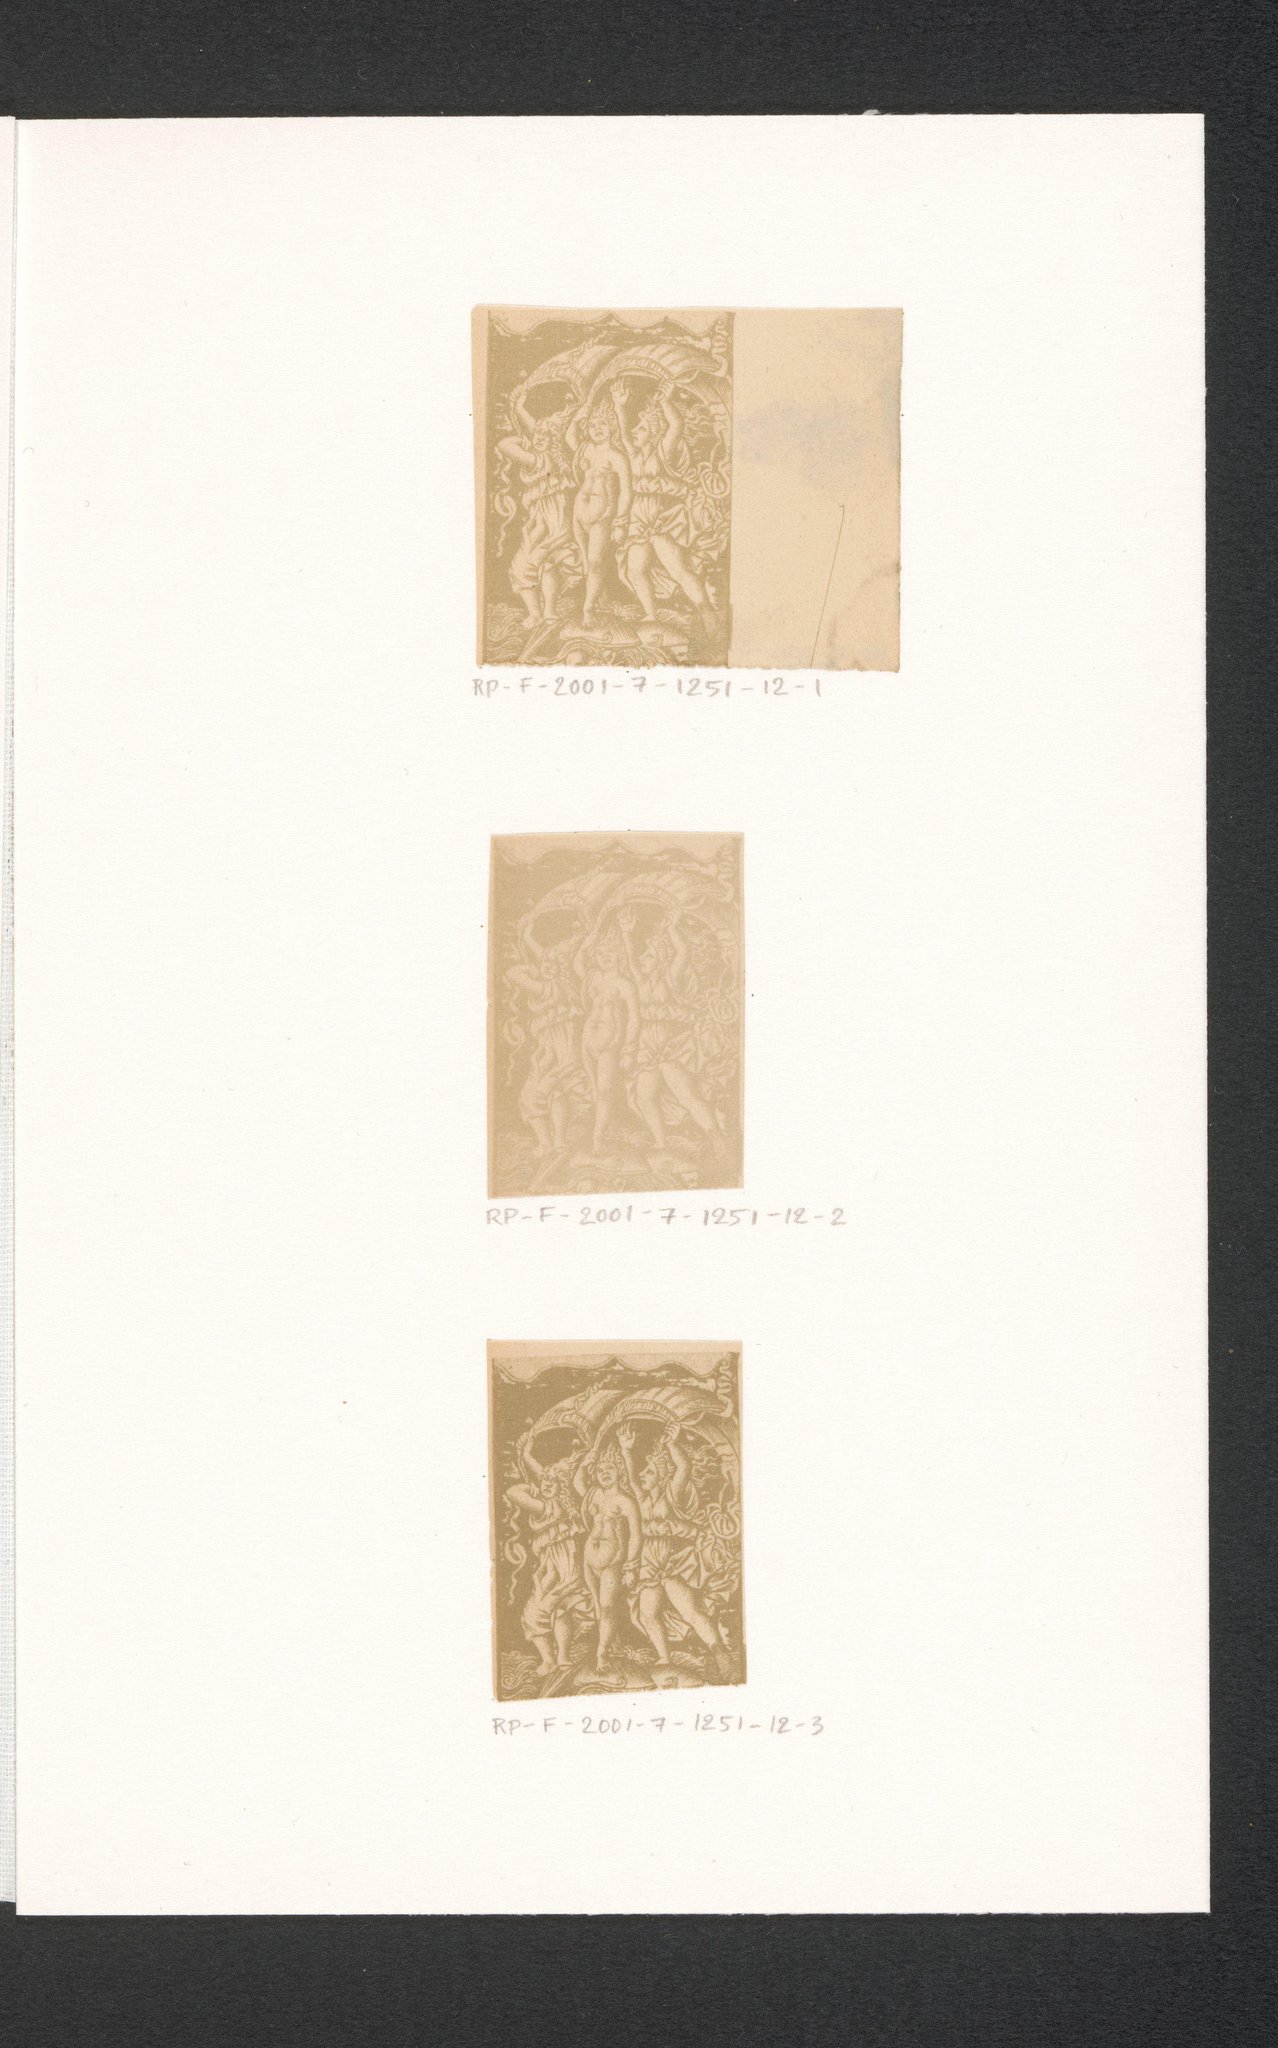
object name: photograph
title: Fotoreproductie van een prent van een allegorie op de navigatie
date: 1852-1857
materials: photographic support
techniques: salted paper print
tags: signalling ~ navigation, symbolic representations, allegories and emblems ~ drawing